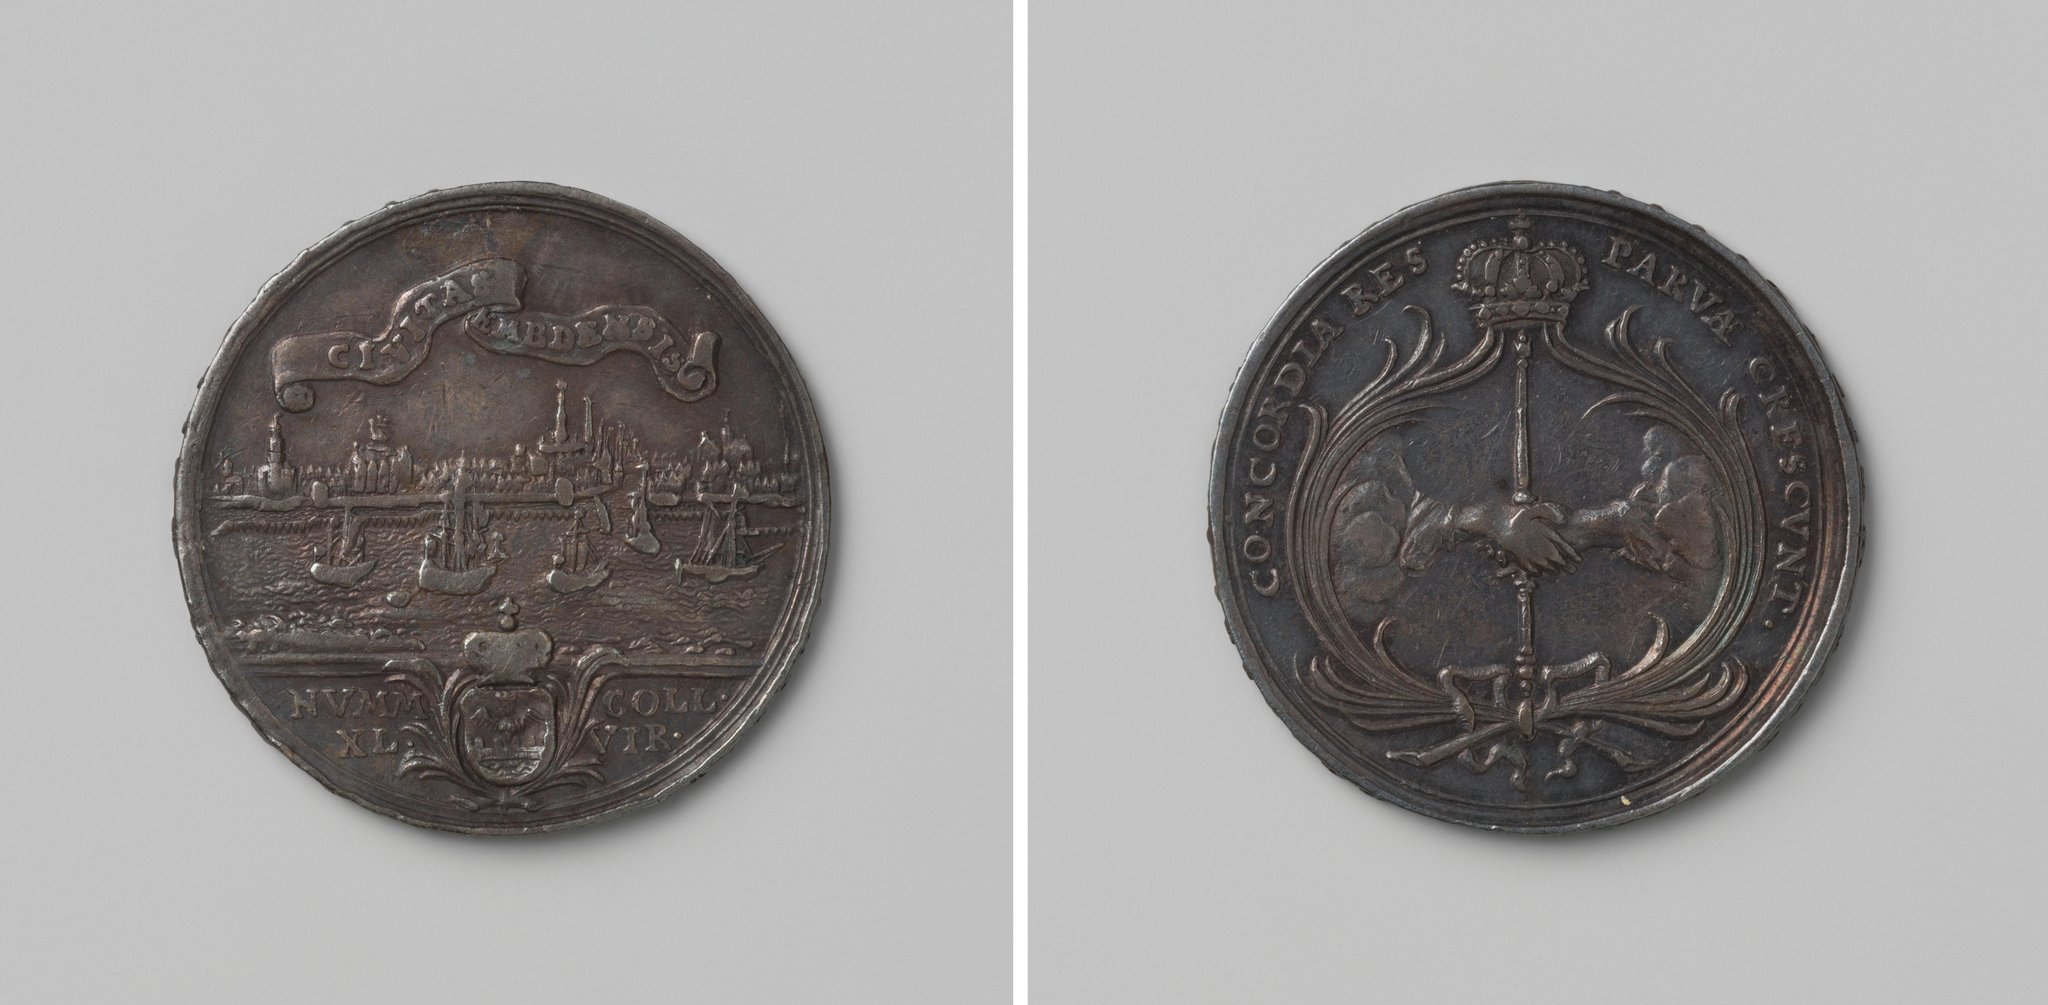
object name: council medal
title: Vroedschapspenning van de stad Embden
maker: Anonymous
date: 1744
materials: silver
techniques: striking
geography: emden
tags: emden